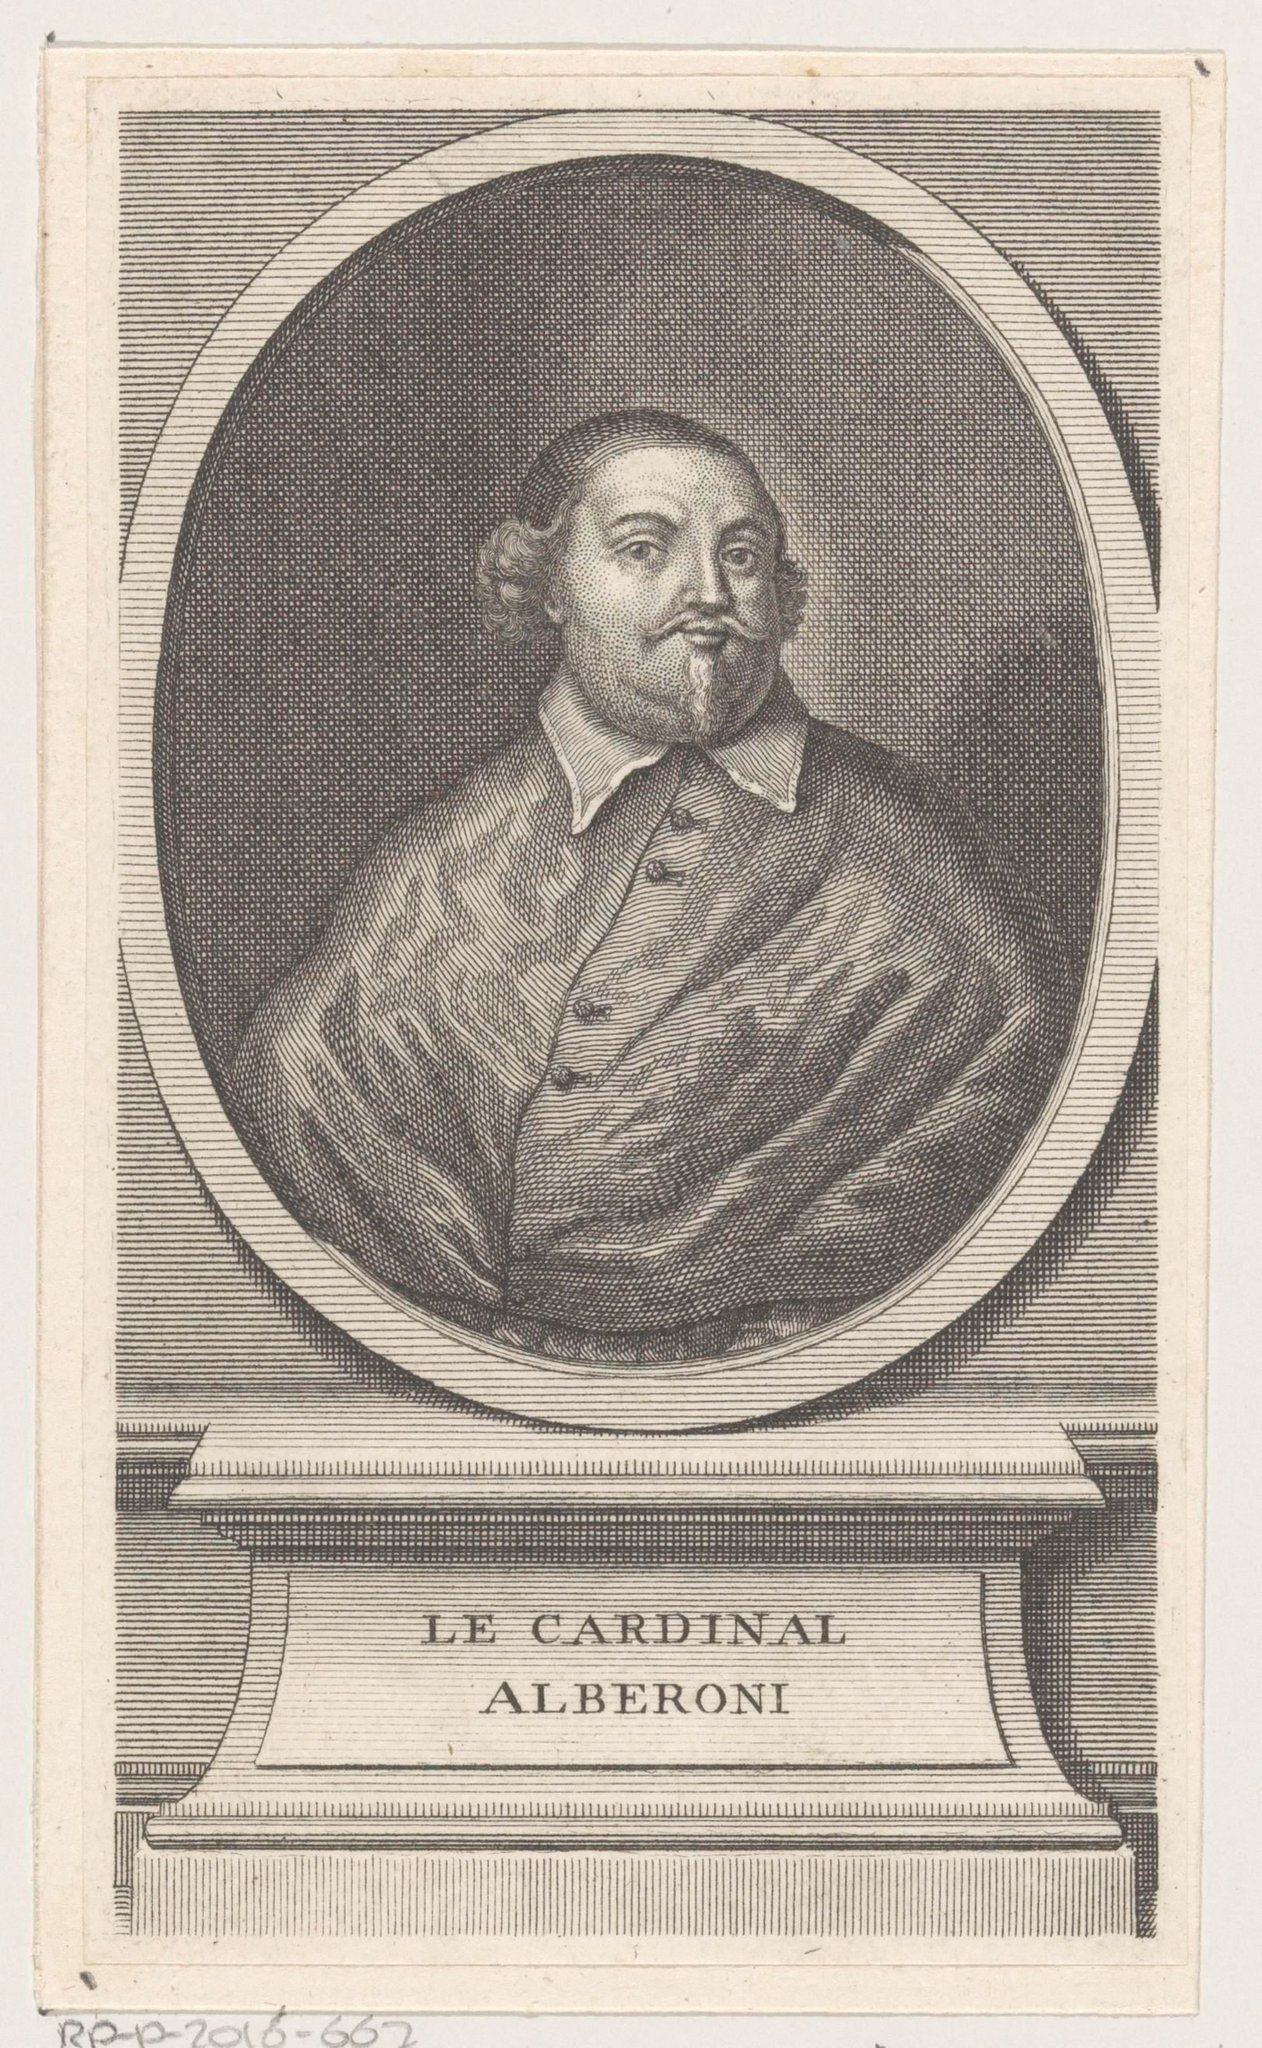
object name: print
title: Portret van kardinaal Giulio Alberoni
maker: Anonymous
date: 1717-1799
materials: paper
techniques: engraving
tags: piacenza, giulio alberoni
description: Portret van kardinaal Giulio Alberoni in een ovale omlijsting. In een kader zijn naam en titel.